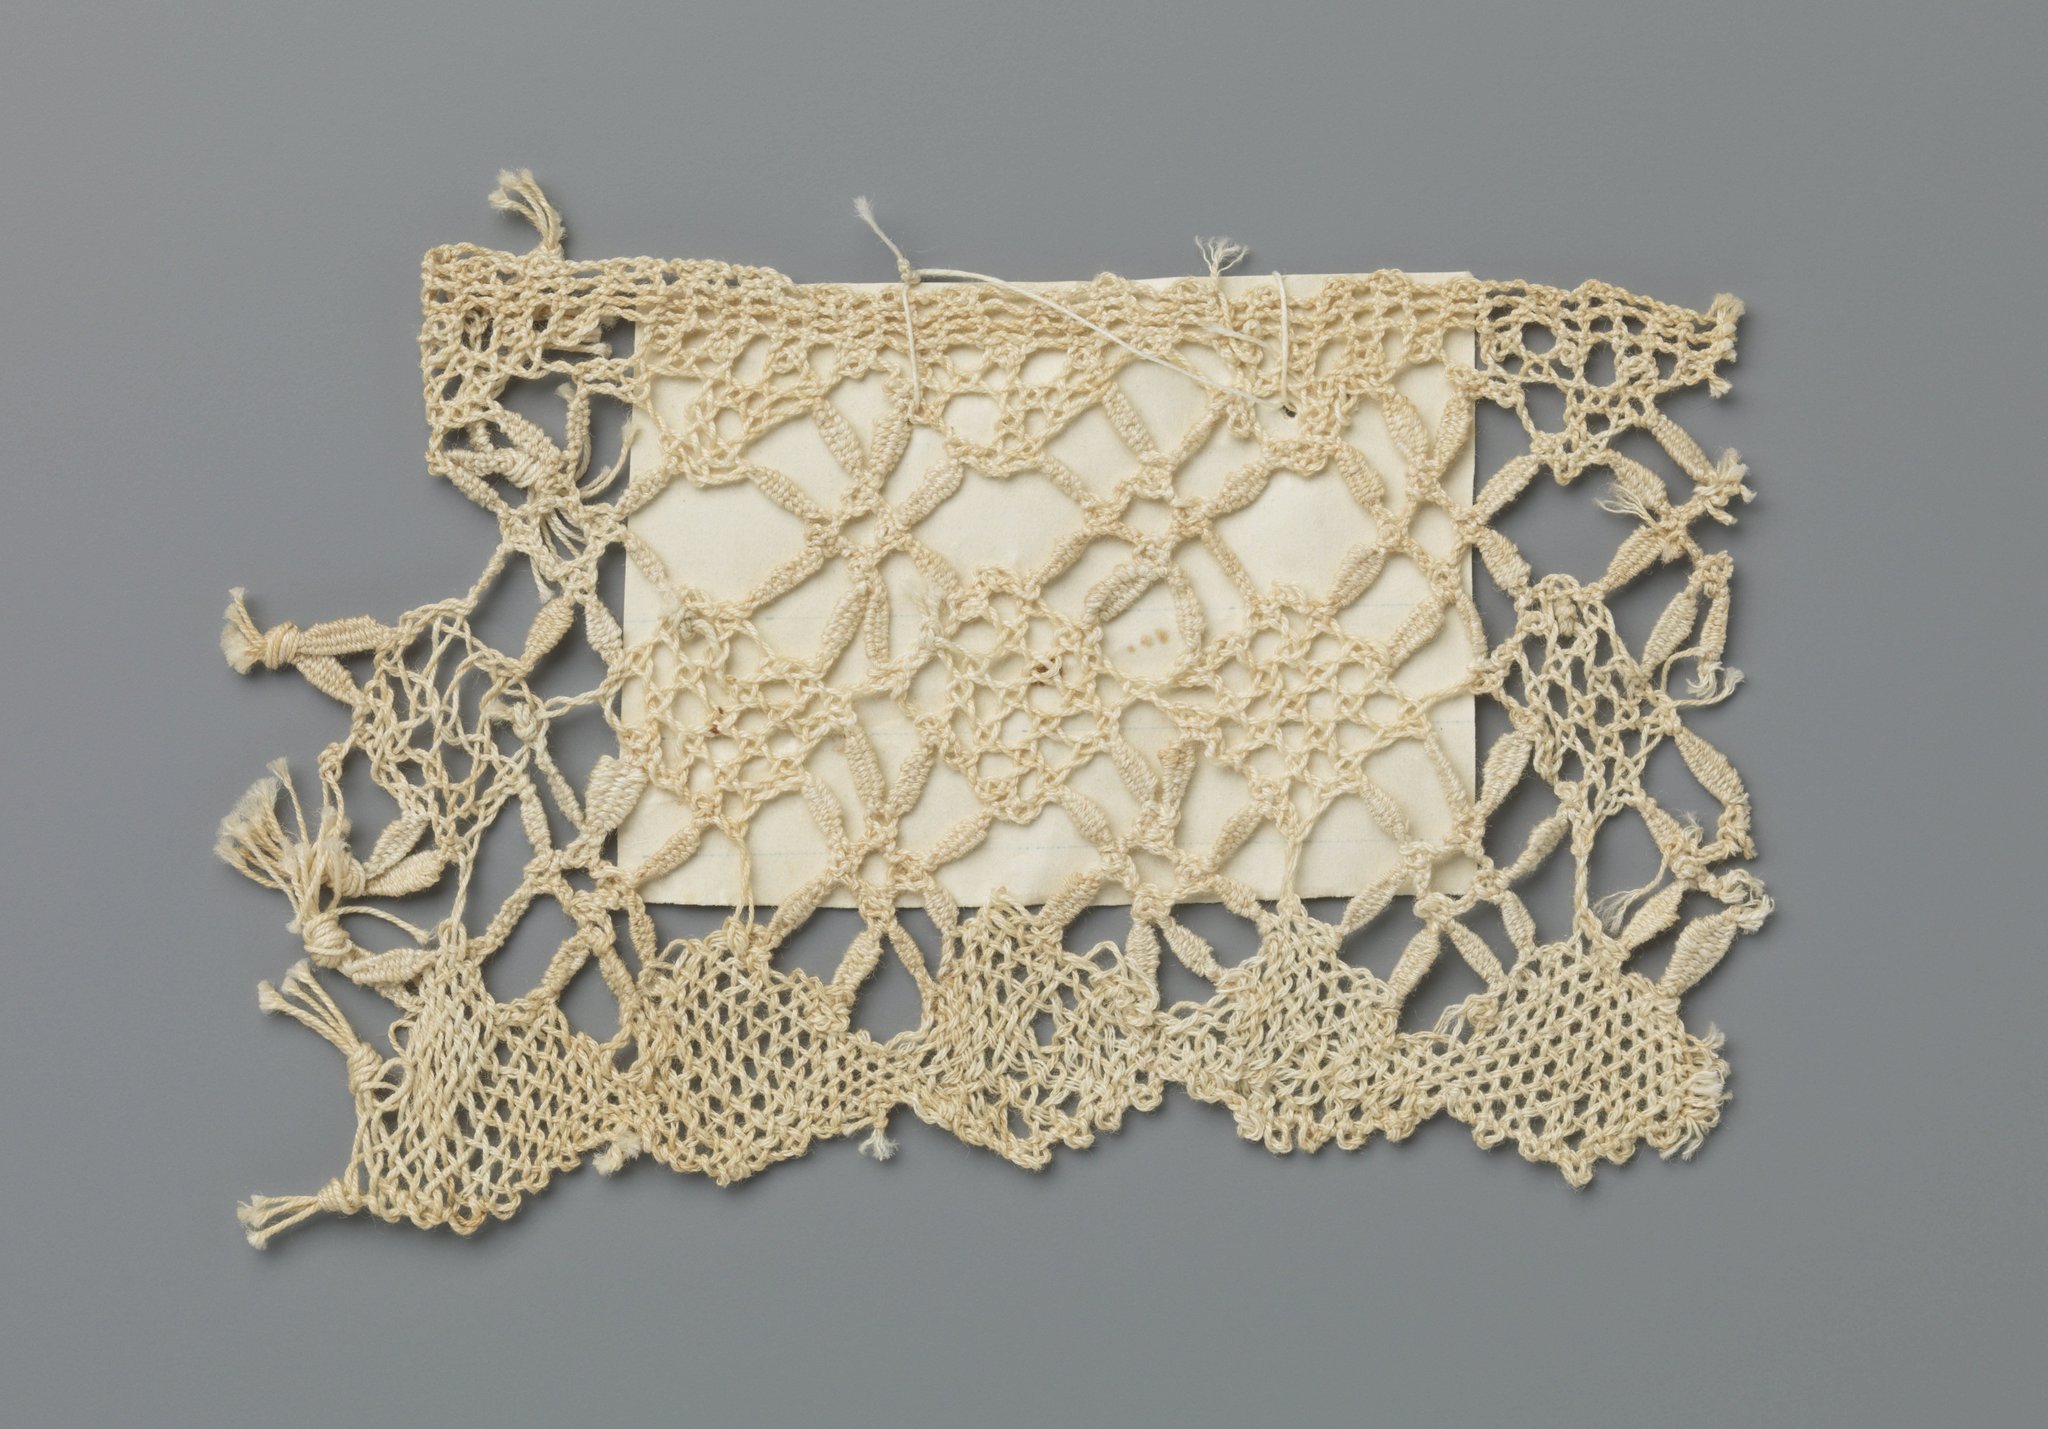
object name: strip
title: Strook kloskant met ruiten Padang niet Sadiah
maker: Anonymous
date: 1917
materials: linen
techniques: lace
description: Strook naturelkleurige kloskant, stropkant. Langs de onderzijde van de strook bestaat het patroon uit een rij ruiten in netslag. Daarboven loopt een rij ruiten met een traliegrond, een vijfgaatjesgrond, tussen grove spinnen. Aan de strook is een etiket genaaid met de tekst: Padang niet Sadiah.